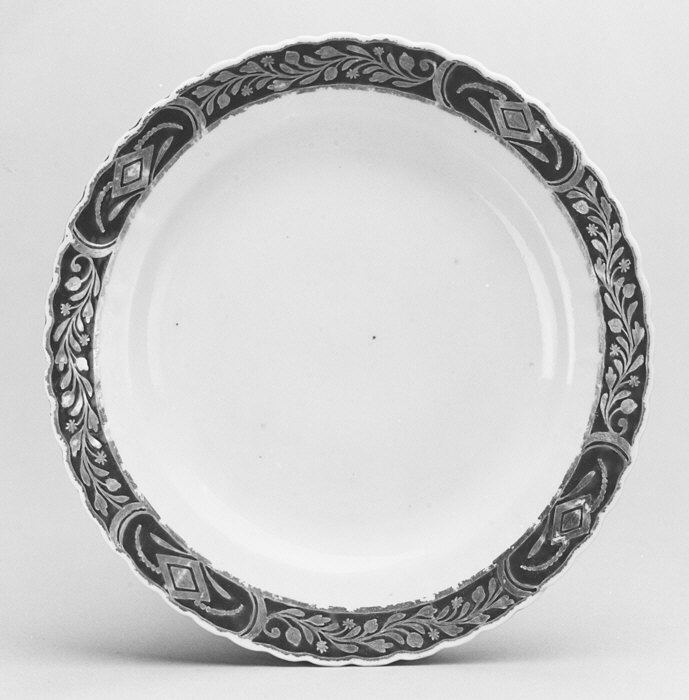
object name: plate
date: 1790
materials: hard paste porcelain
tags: flowers